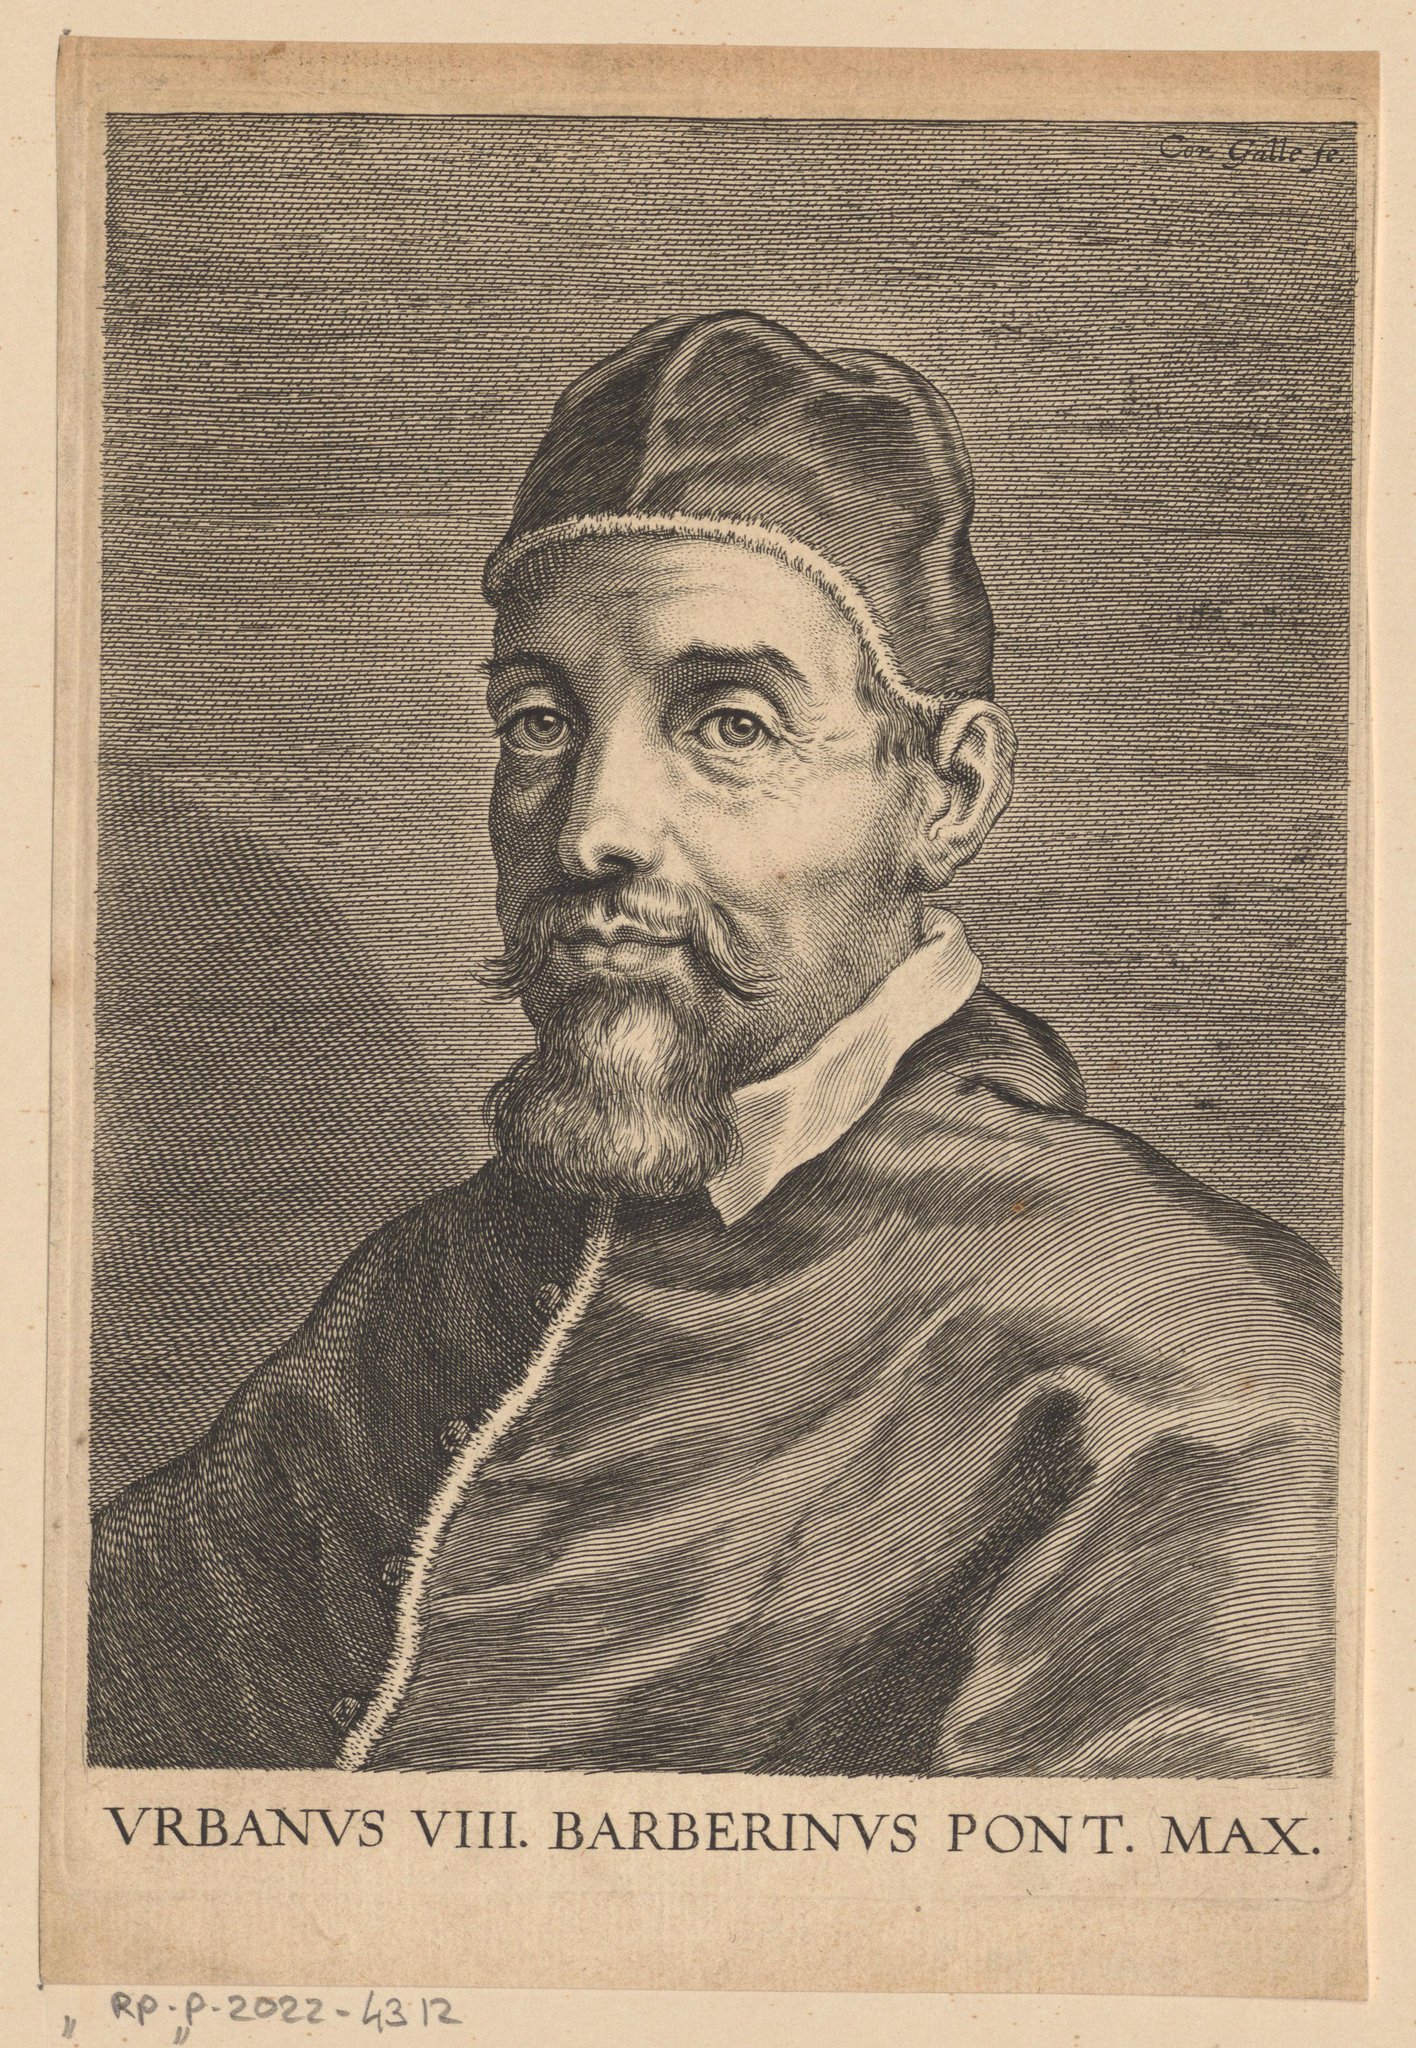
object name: print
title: Portret van paus Urbanus VIII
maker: cornelis galle (i)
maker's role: print maker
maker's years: 1576-1650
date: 1623-1650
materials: paper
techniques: engraving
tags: rome, clergyman, urbanus viii, historical persons, pope